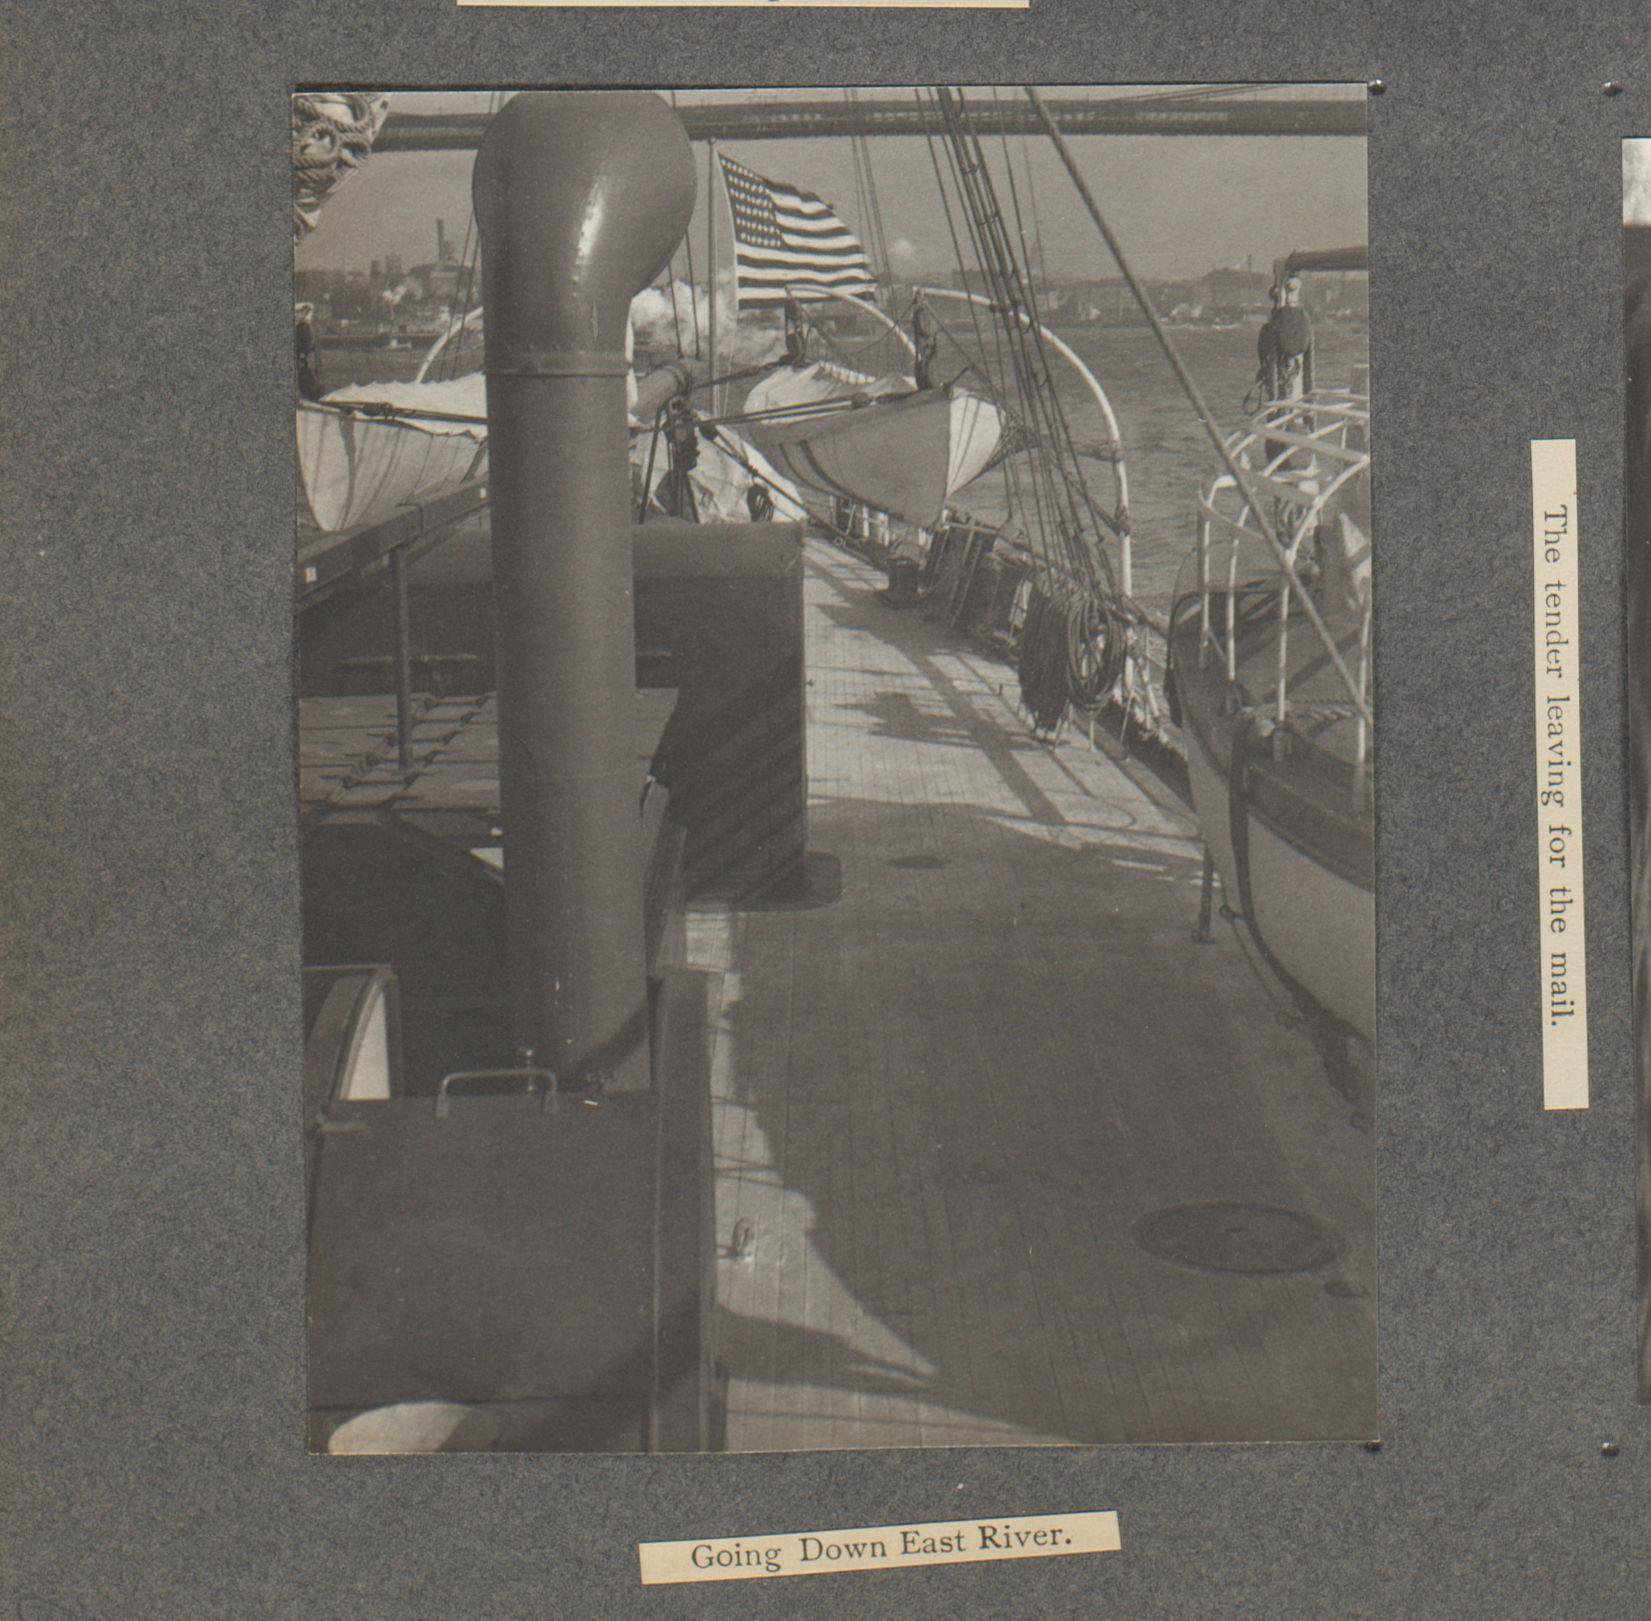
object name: photograph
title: Voordek van de Columbia, varend over East River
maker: Anonymous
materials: paper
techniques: platinum process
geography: new york city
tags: parts of ship's exterior, river, prospect of city, town panorama, silhouette of city